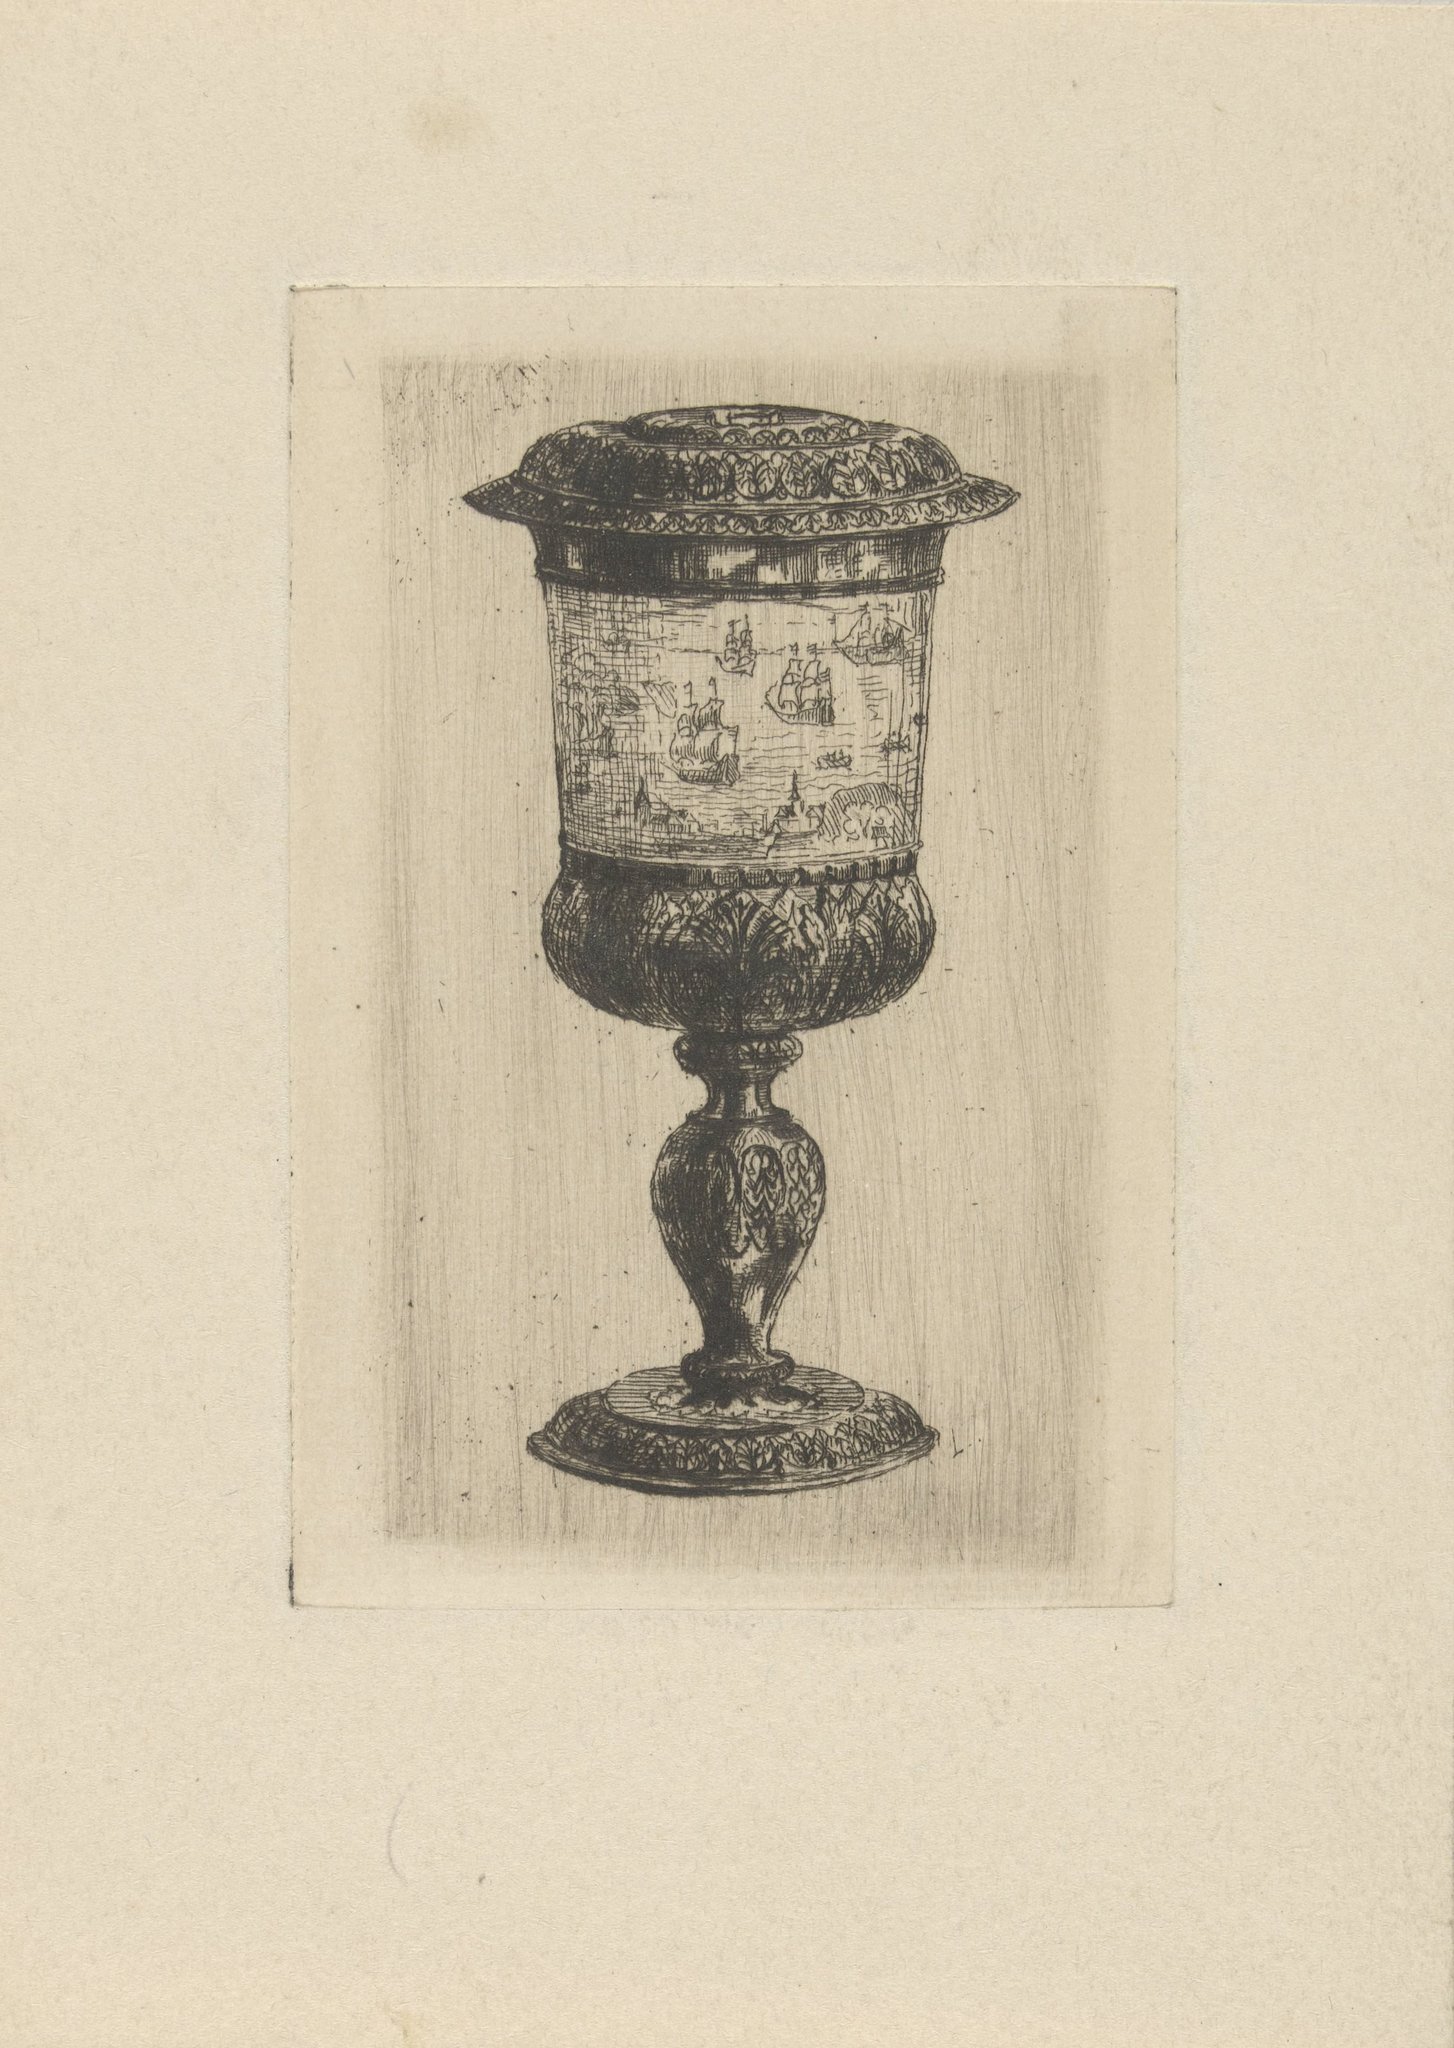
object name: print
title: Gouden beker met deksel, geschonken aan Michiel de Ruyter ter gelegenheid van de Tocht naar Chatham, 1667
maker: jonkheer barthold willem floris van riemsdijk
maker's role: engineer, print maker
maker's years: 1850-1942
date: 1894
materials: paper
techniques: drypoint, etching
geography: netherlands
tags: sailing-ship, sailing-boat, bowl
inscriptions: collector's mark: Lugt 2228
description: Afbeelding van de gouden beker met los deksel, vervaardigd door zilversmid Nicolaes Loockemans met in emaille er op uitgebeeld de gebeurtenissen tijdens de Tocht naar Chatham van 20-23 juni 1667. De beker werd geschonken aan admiraal Michiel de Ruyter op 7 november 1667.